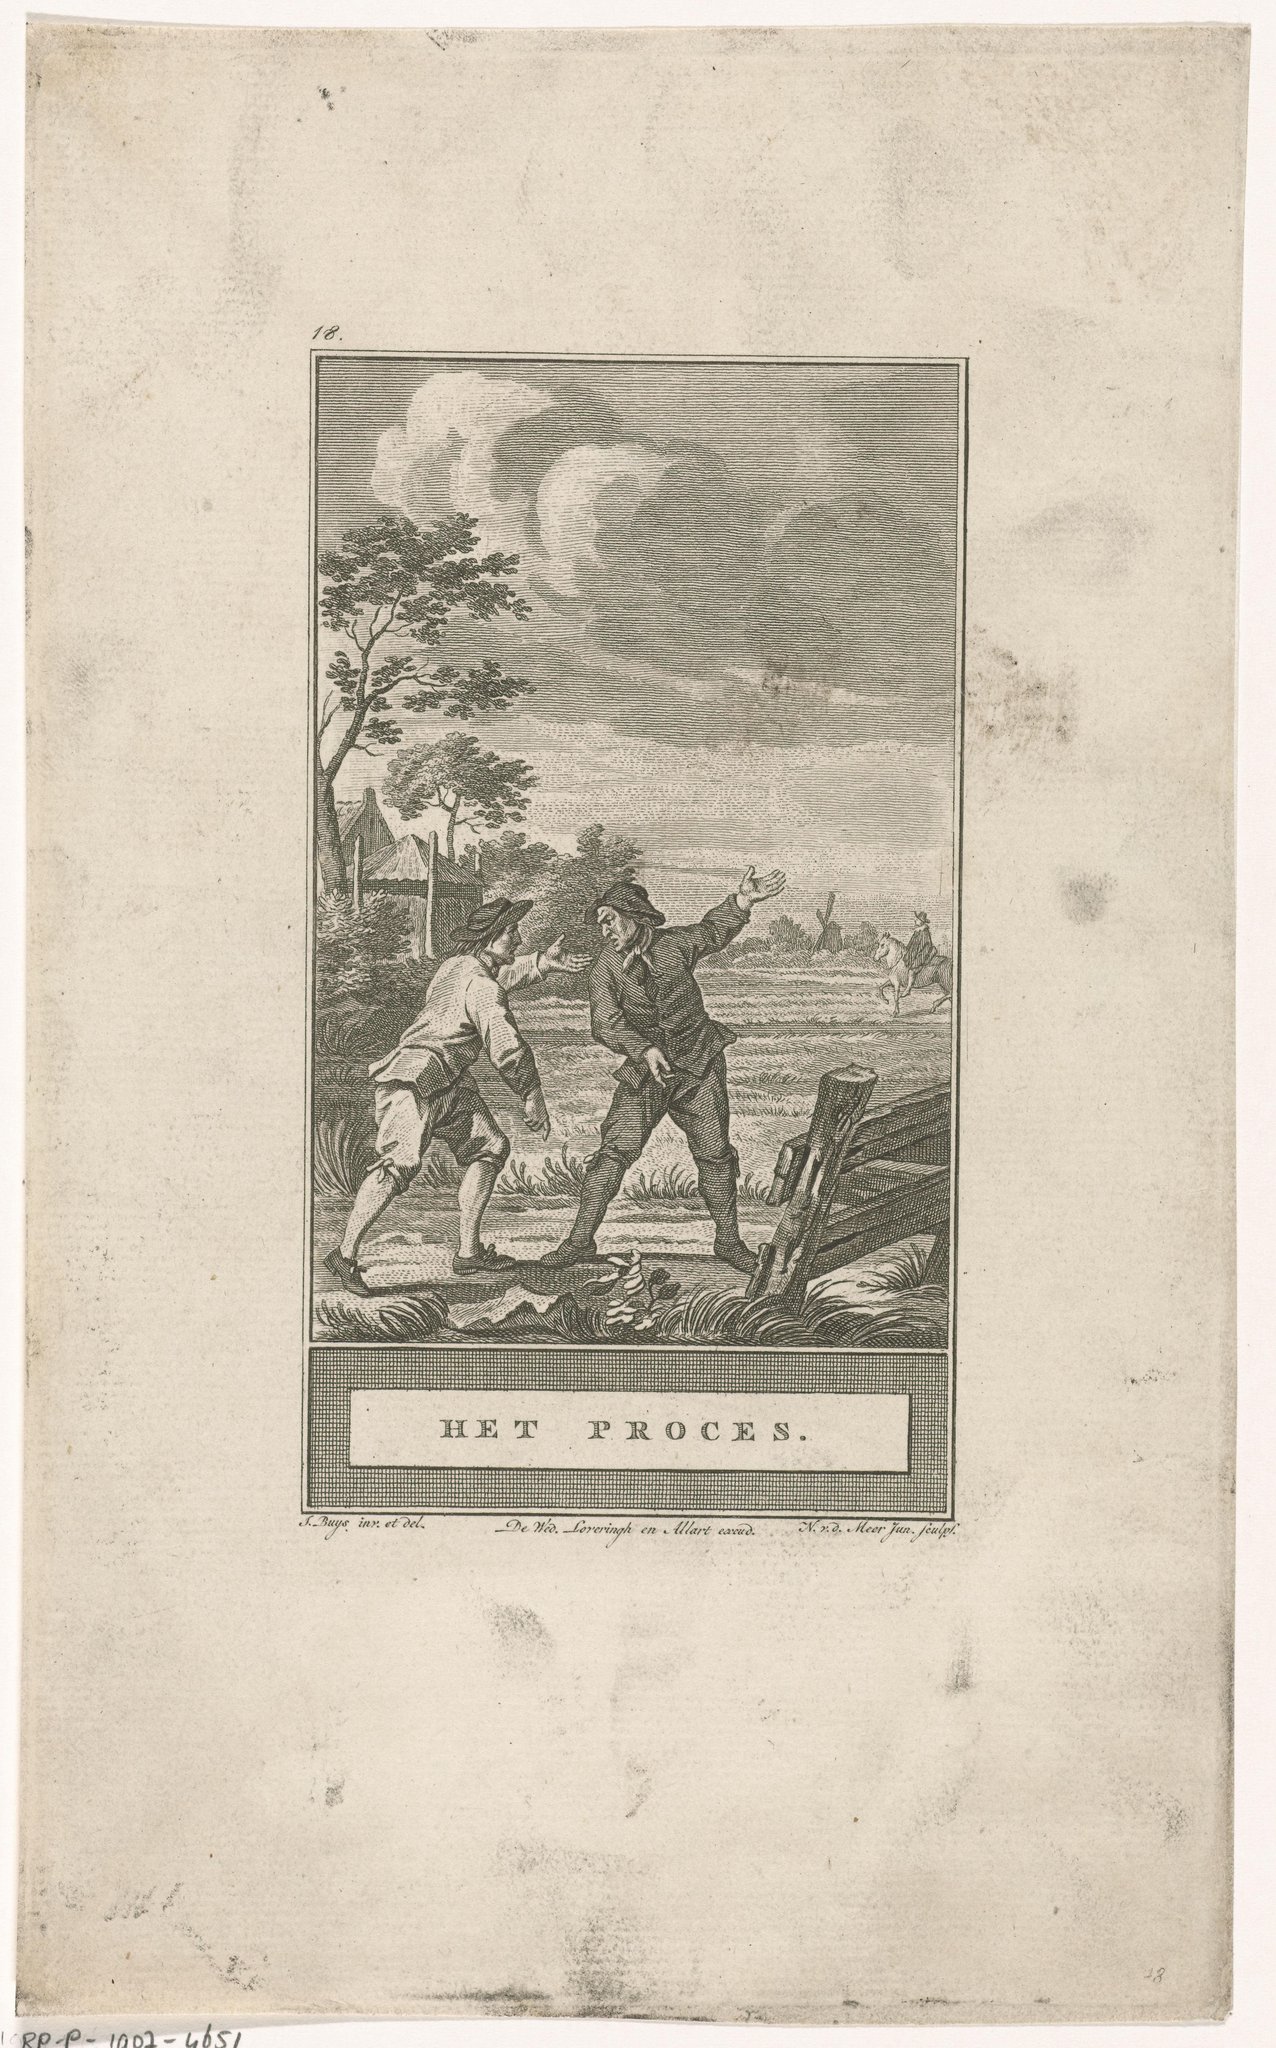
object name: print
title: Burenruzie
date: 1777-1778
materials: paper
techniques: etching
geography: amsterdam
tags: neighbour, landscapes in the temperate zone, quarrel, argument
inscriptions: collector's mark: Lugt 2228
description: Prent bij: Gellert, Christian Fürchtegott. Fabelen en vertelsels. 3 dln. Amsterdam: Pieter Meyer, 1772-1774. De prenten bij deze publicatie werden later uitgegeven. De exemplaren uitgegeven door de weduwe Jacobus Loveringh & Johannes Allart tussen 1777 en 1778, de exemplaren uitgegeven door alleen Johannes Allart tussen 1778 en 1785.